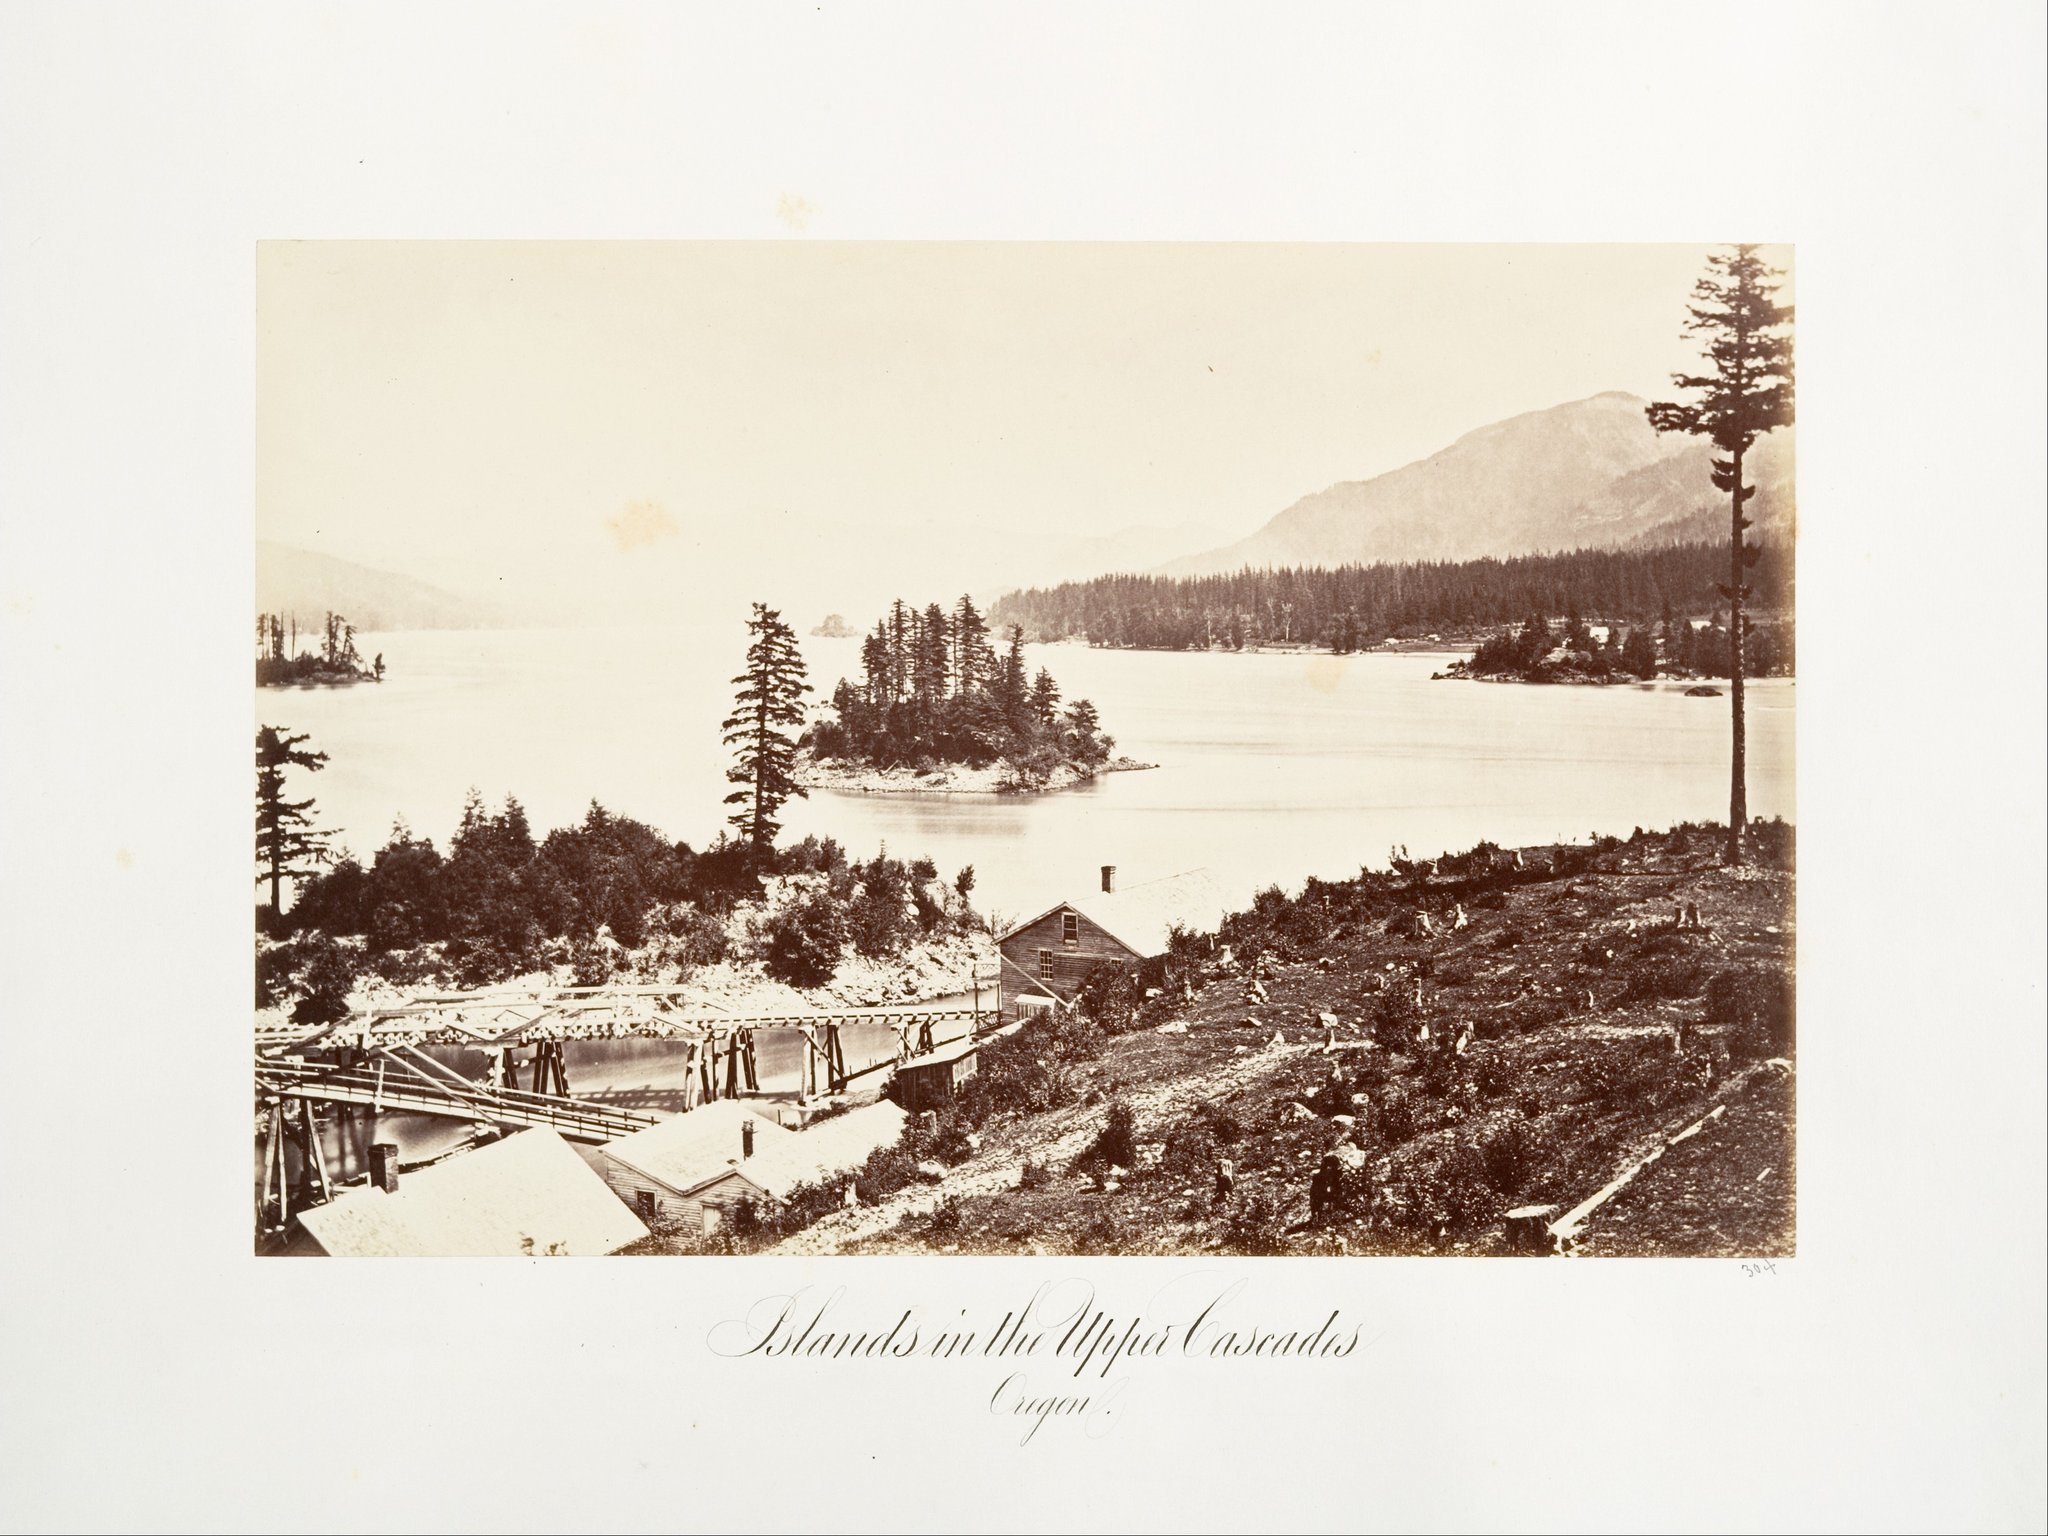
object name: photograph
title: Islands in the Upper Cascades, Oregon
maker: carleton e. watkins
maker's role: artist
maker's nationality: american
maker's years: 1829-1916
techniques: albumen silver print, glass negative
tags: bridges,mountains,landscapes